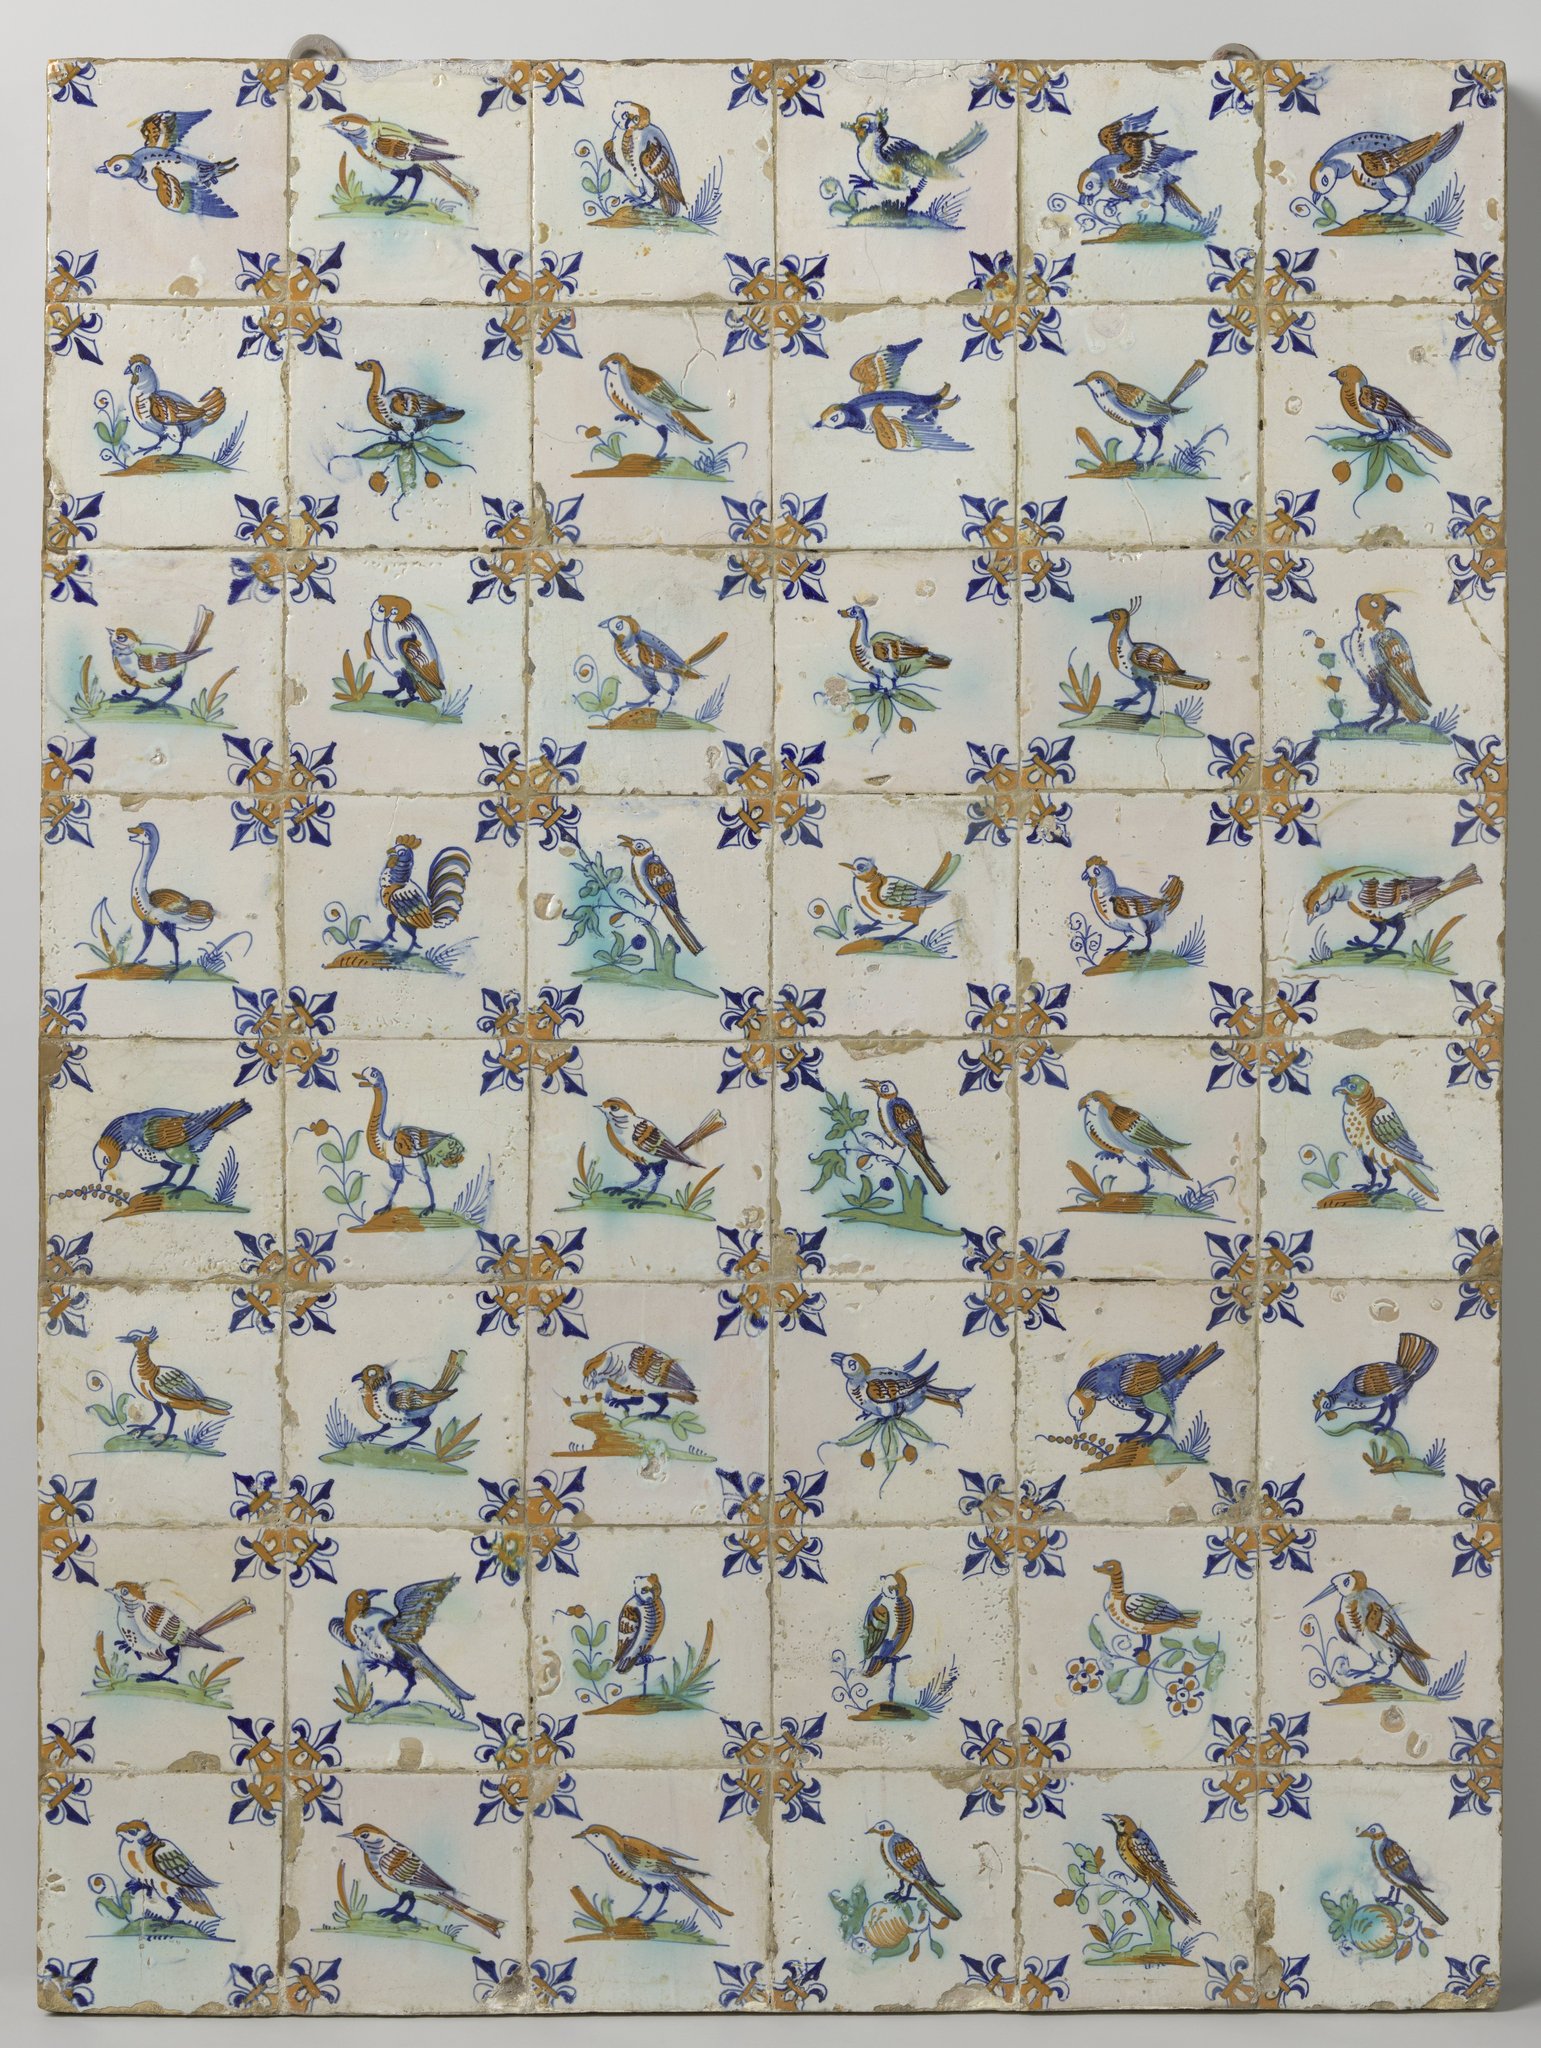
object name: tegelveld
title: Veld van achtenveertig tegels met vogels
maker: Anonymous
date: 1640-1660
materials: earthenware, glaze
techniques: maiolica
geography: netherlands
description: Veld van achtenveertig tegels (8 x 6) met veelkleurige (blauw, groen, oranje, geel, paars en grijs) vogels op een grond. In de hoeken, een lelie.